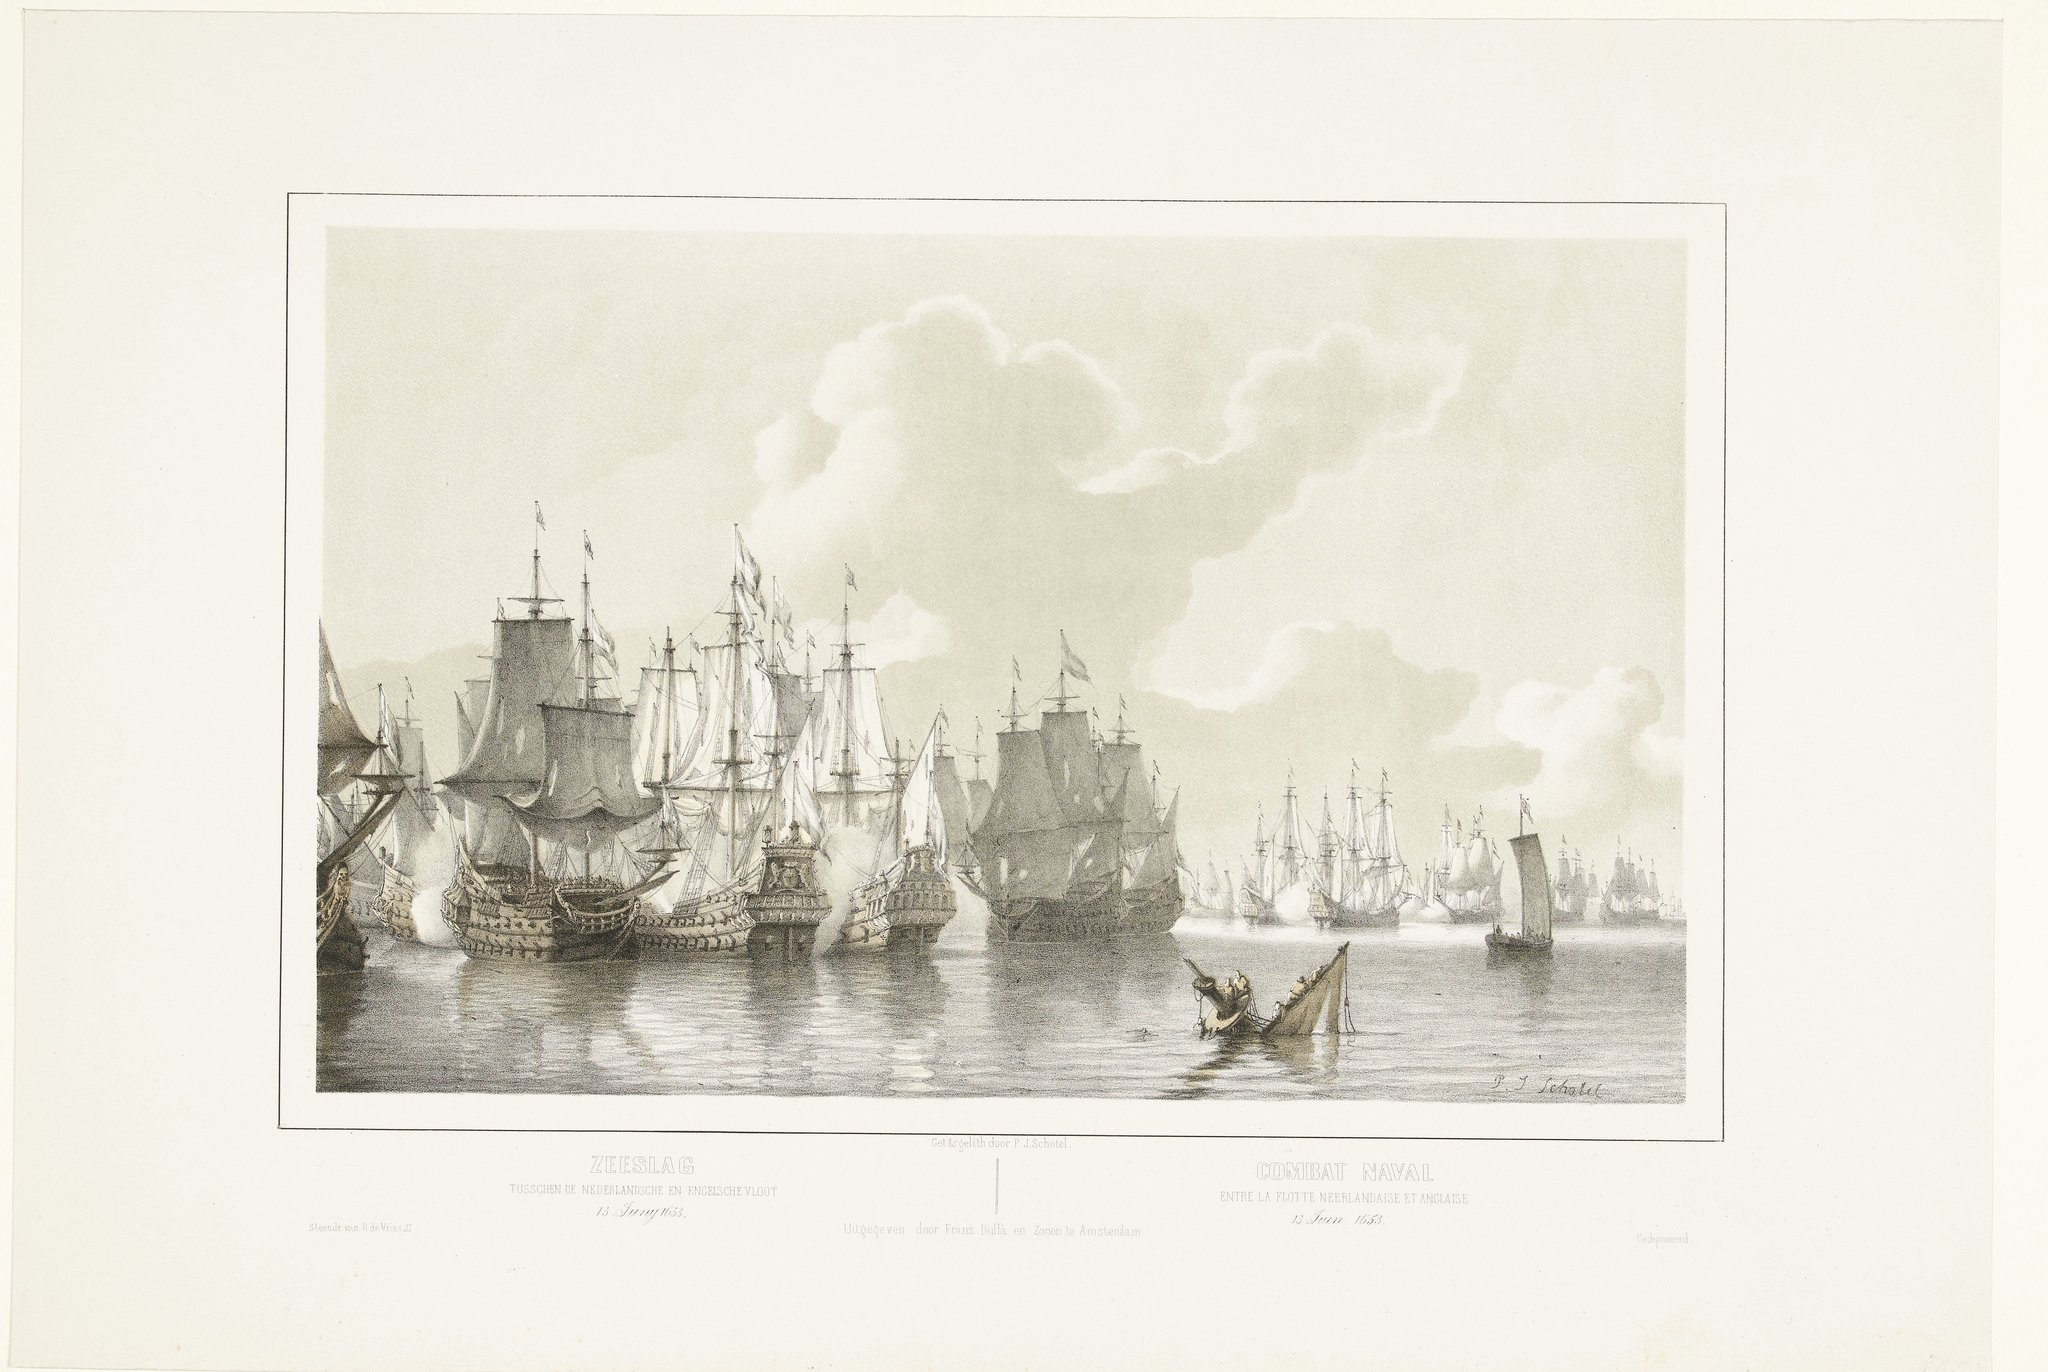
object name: history print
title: Zeeslag tusschen de Nederlandsche en Engelsche vloot 13 Juny 1653 / Combat naval entre la flotte Neerlandaise et Anglaise 13 Juin 1653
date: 1848-1855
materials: paper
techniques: lithograph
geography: netherlands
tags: maarten harpertszoon tromp, battle (+ naval force), battle of the gabbard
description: Uitgegeven in: P.J. Schotel, Heldendaden der Nederlanders ter zee, van de vroegste tijden tot op heden, naar aanleiding van de: Geschiedenis van het Nederlandsche zeewezen, Frans Buffa en Zonen, Amsterdam 1850-1855, pl. 20. Zonder de uitvoerige beschrijving vermeld bij Muller.